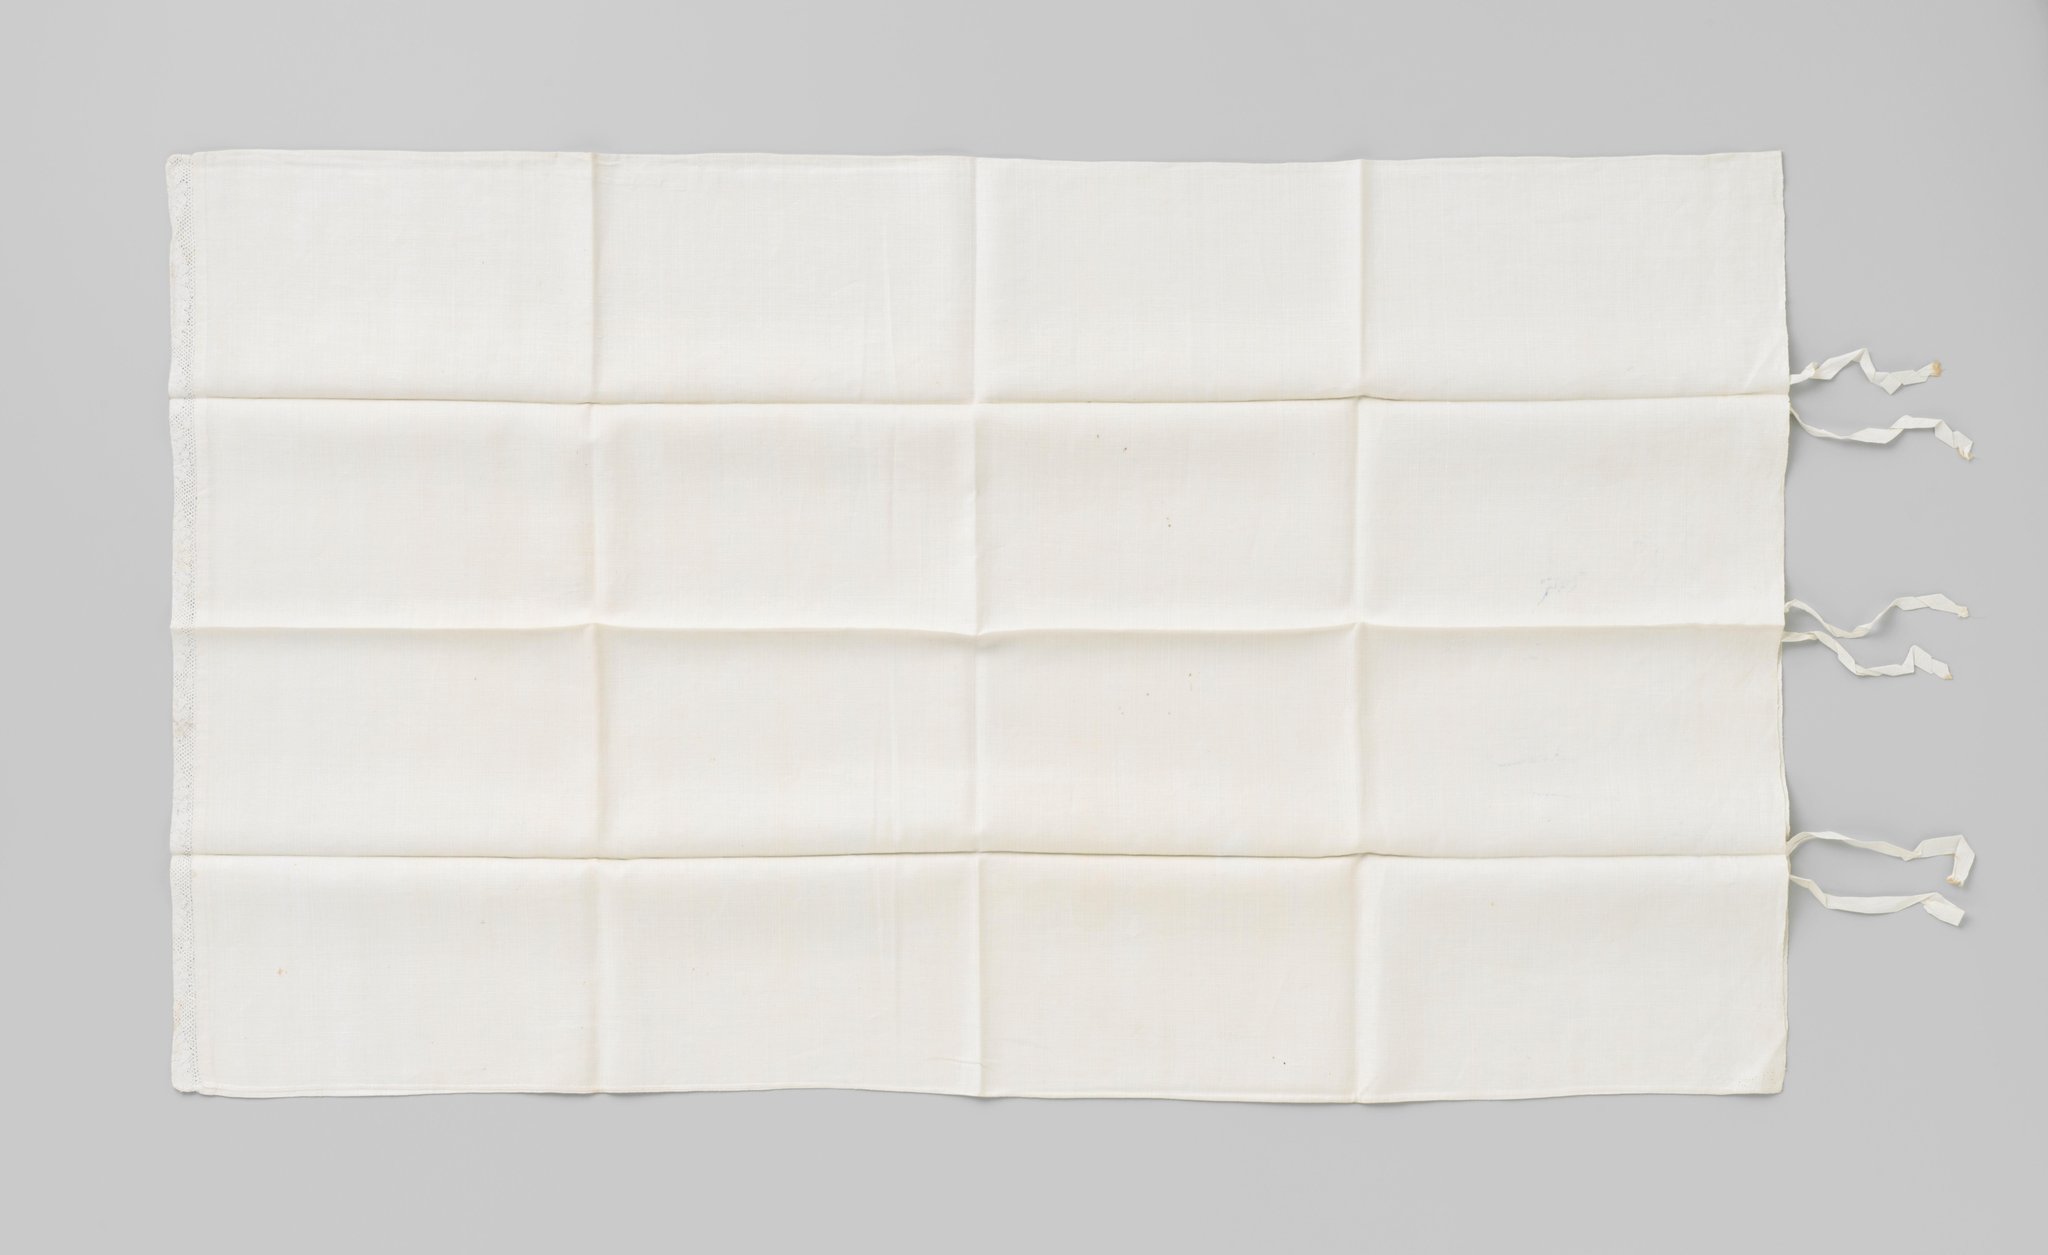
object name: sloop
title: Kussensloop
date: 1700-1750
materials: linen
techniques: lace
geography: northern netherlands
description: Kussensloop van linnen met aan een uiteinde kloskant. Gemerkt kroon B8